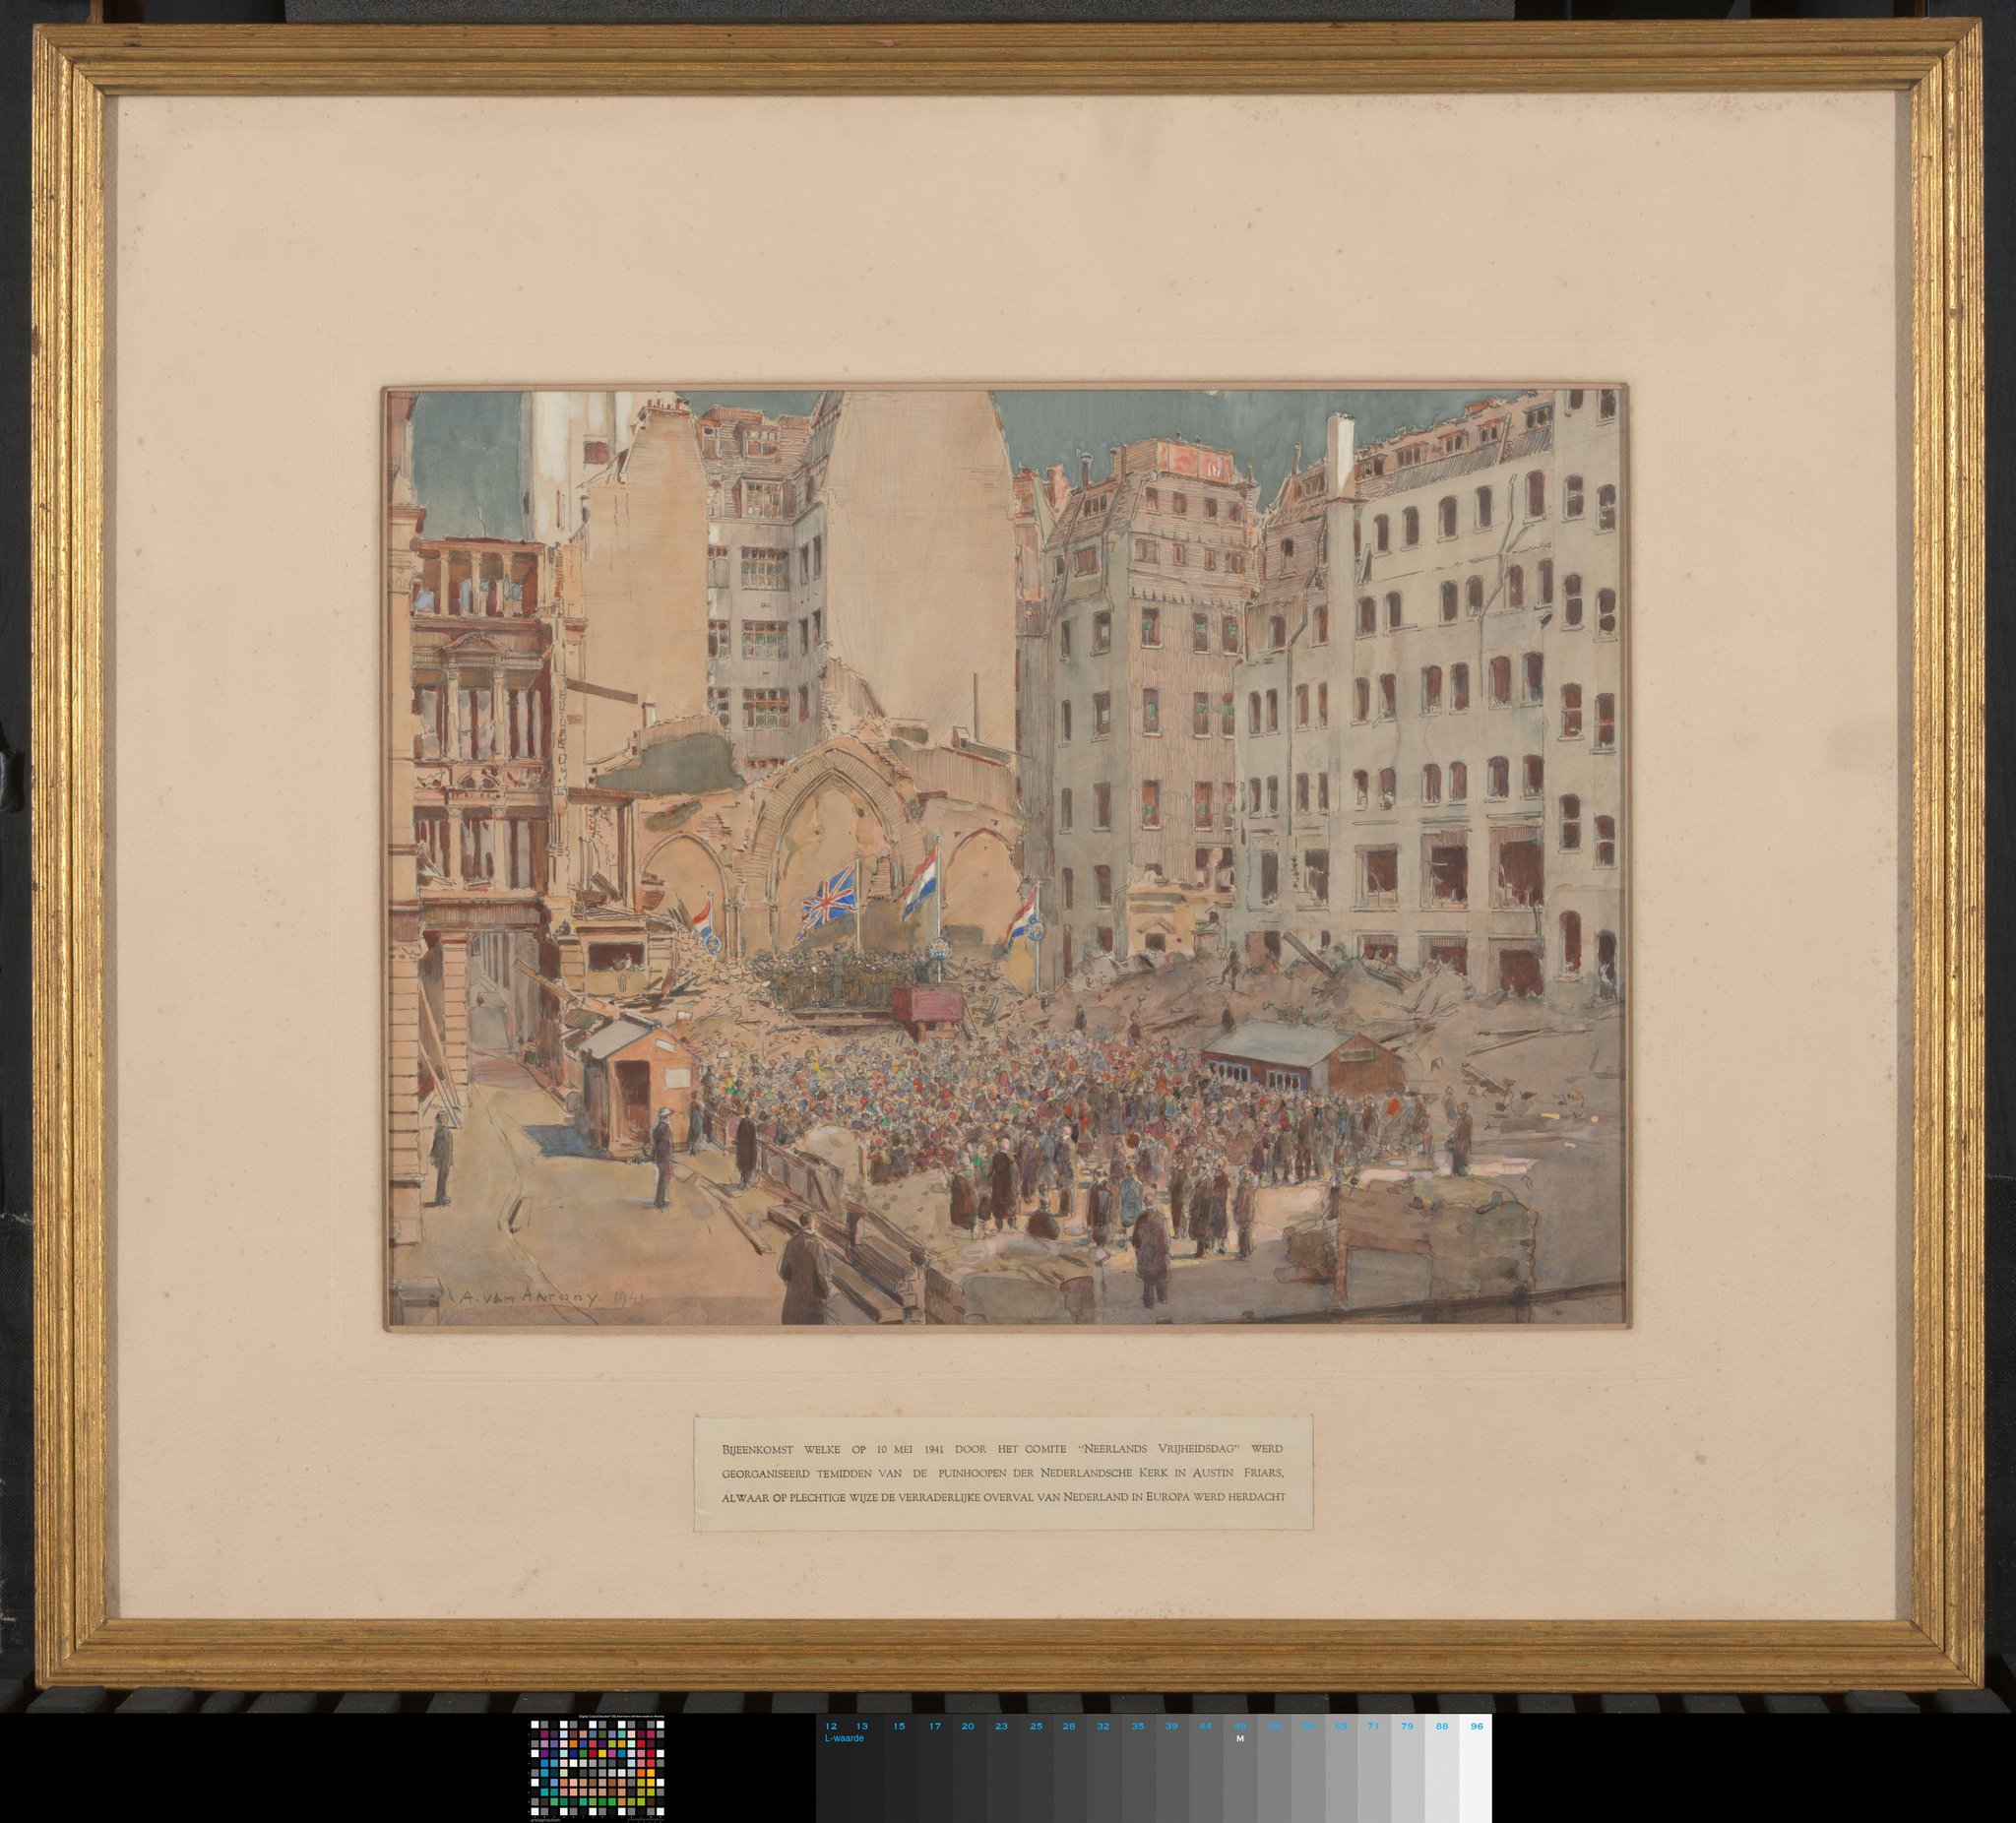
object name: watercolor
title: Herdenkingsbijeenkomst Duitse inval in Nederland op de resten der Ned. Kerk te Austin Friars, Londen 1941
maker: anton abraham van anrooy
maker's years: 1870-1949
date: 1941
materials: glass, paper, pencil, watercolor, wood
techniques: brush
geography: london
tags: london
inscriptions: date